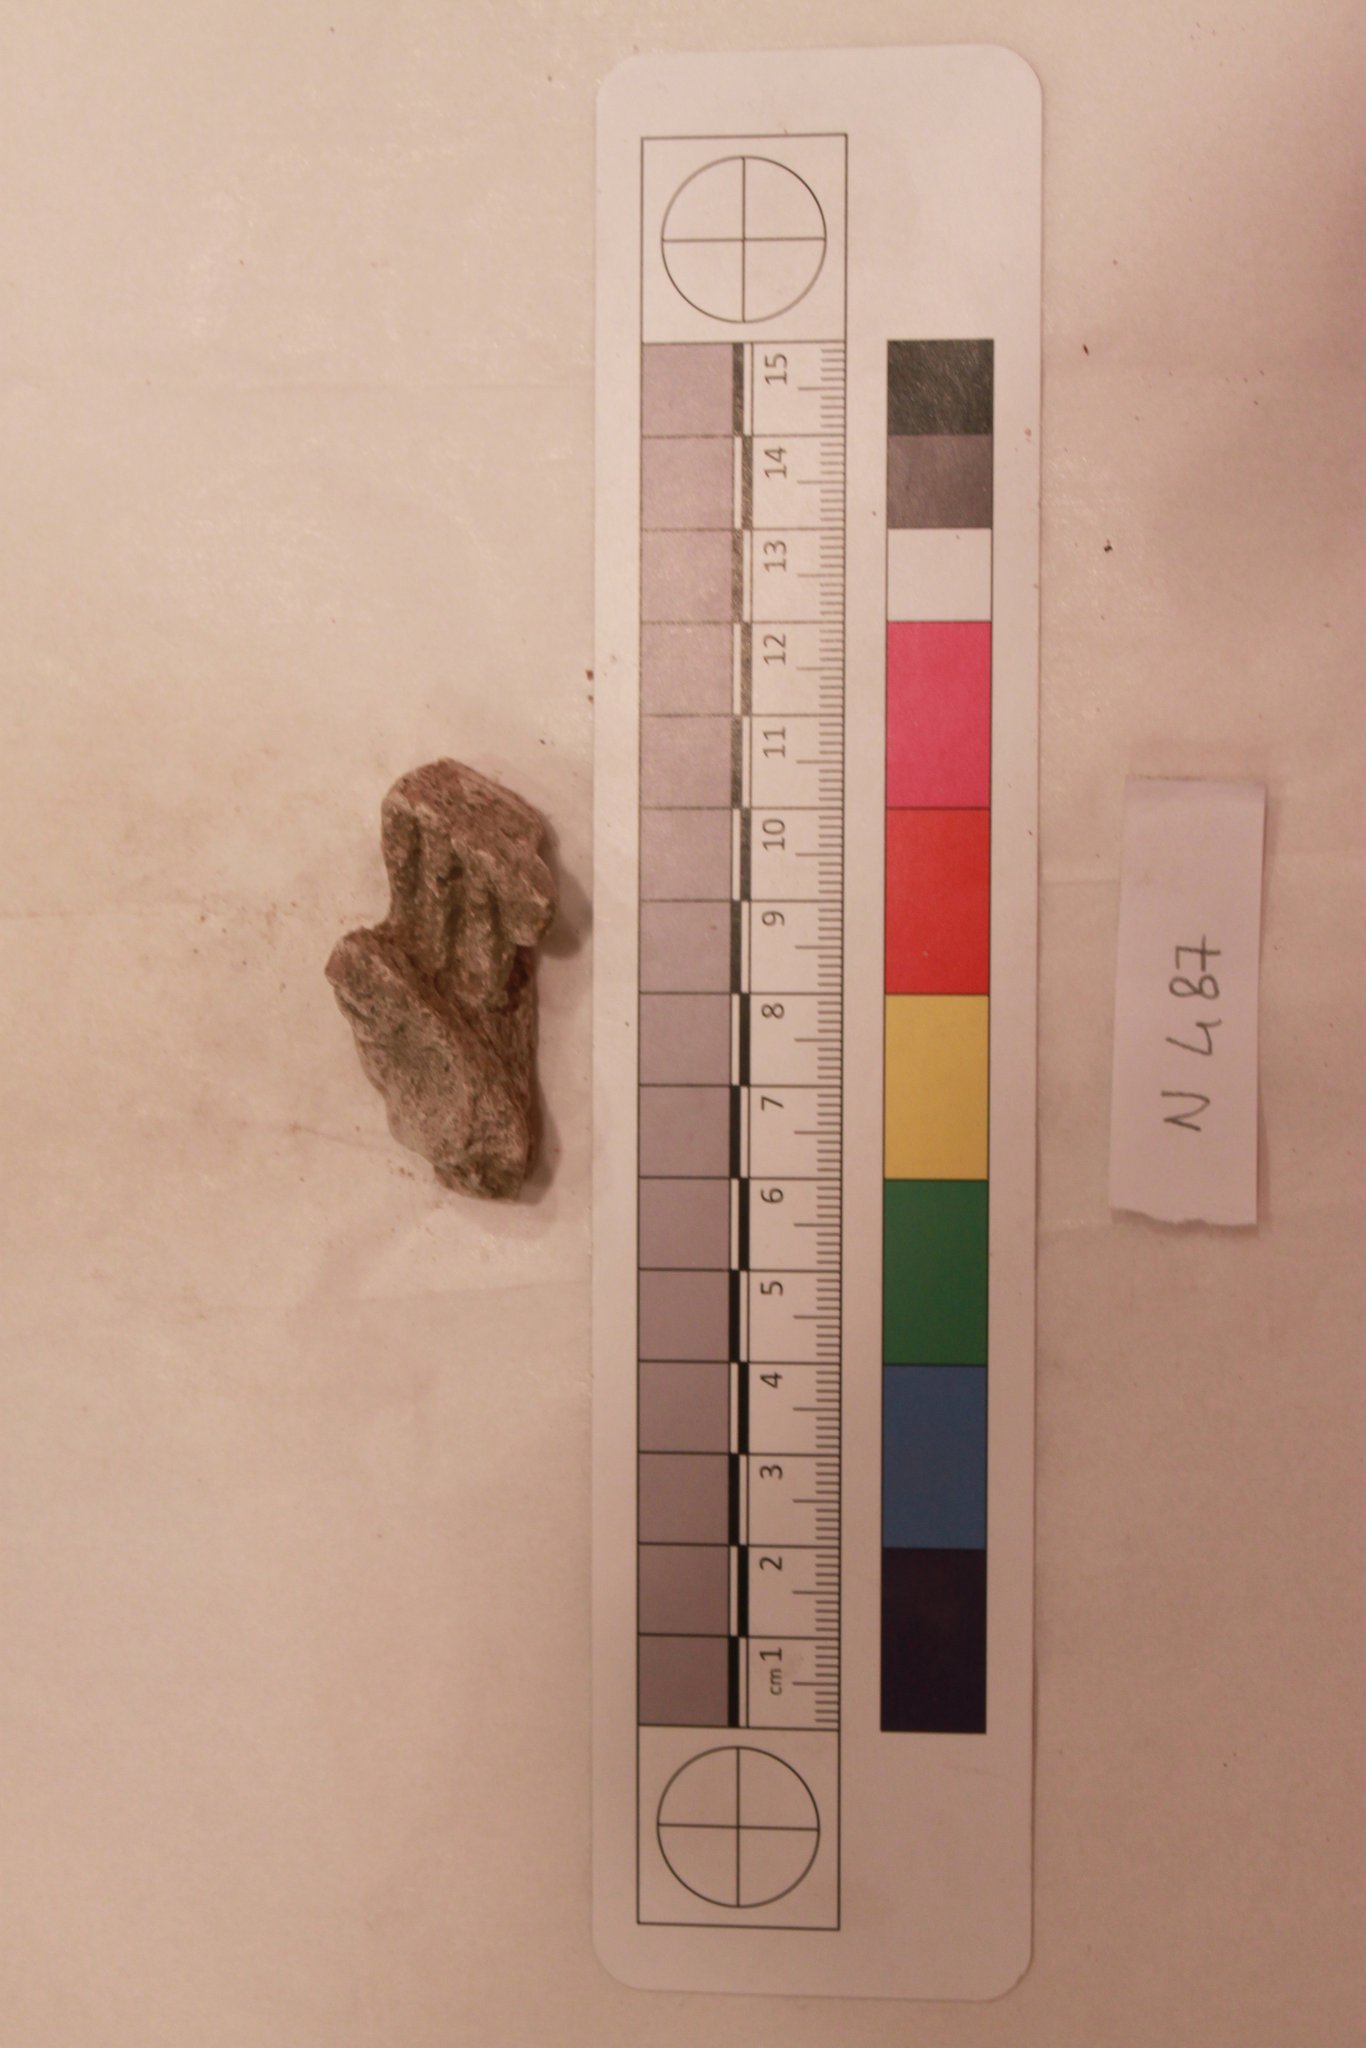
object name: fragment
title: Stucco Fragment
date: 701-1200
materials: plaster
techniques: carving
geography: iran